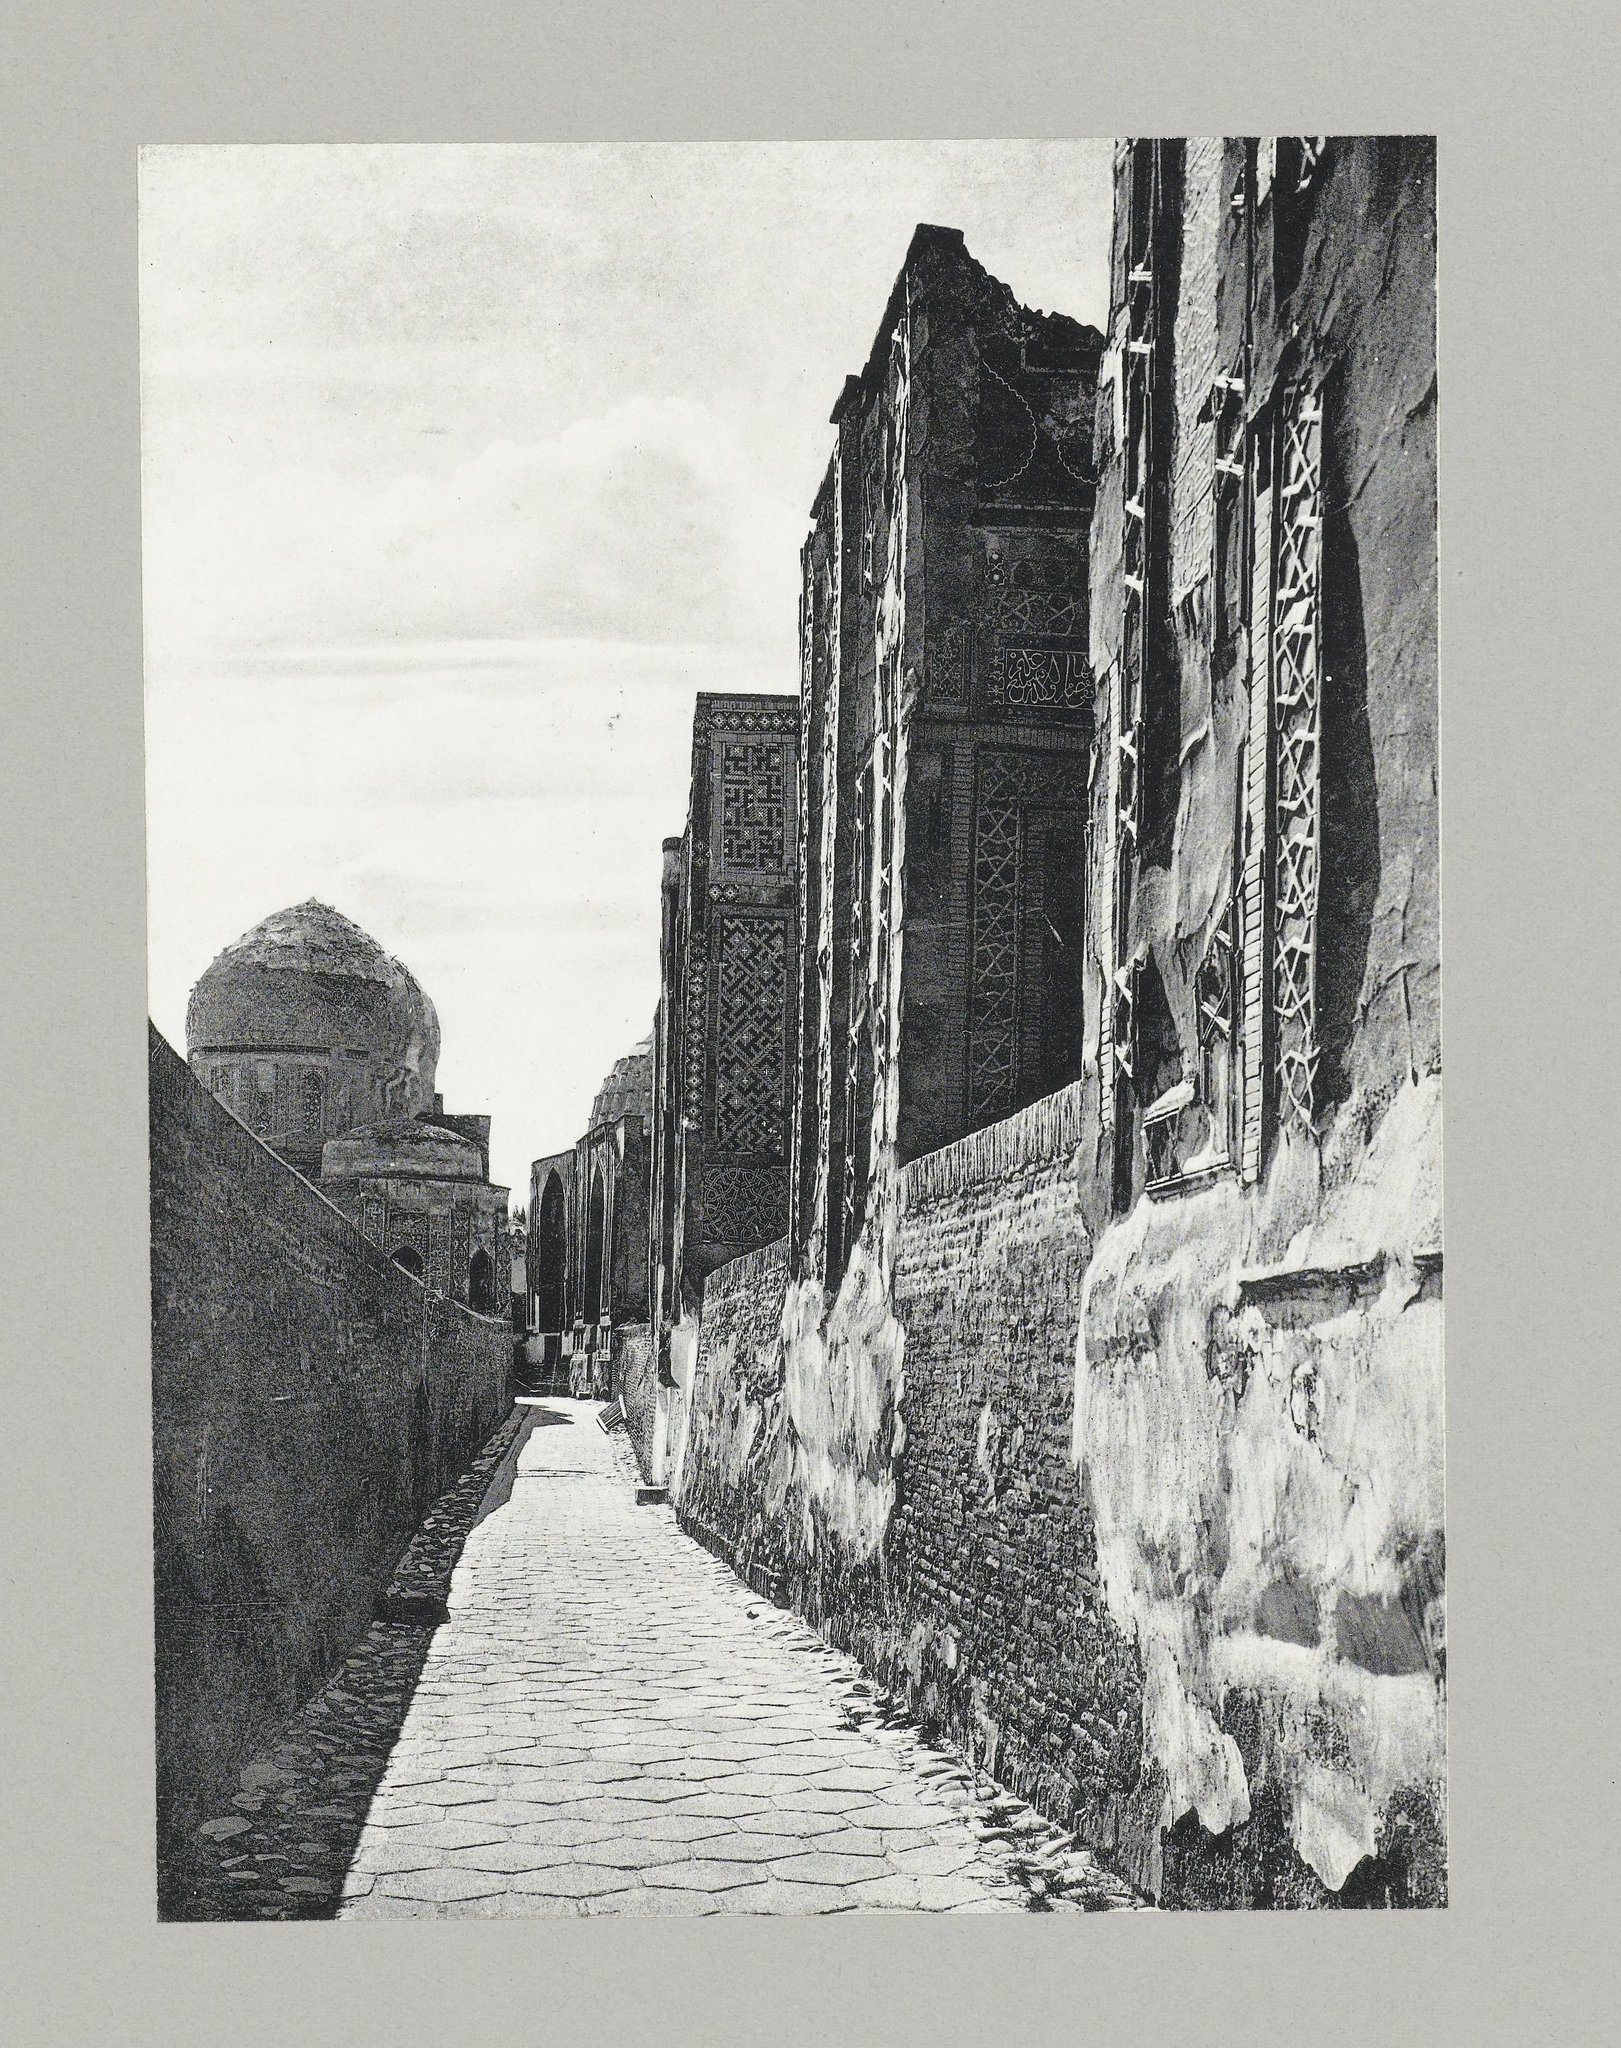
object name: photomechanical print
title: Pad langs groep mausoleums te Samarkand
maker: Anonymous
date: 1895-1915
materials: cardboard, paper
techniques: photograph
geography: samarqand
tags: samarqand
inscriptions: annotation: ‘13. Groep van Mausoleums te Samarkand.’